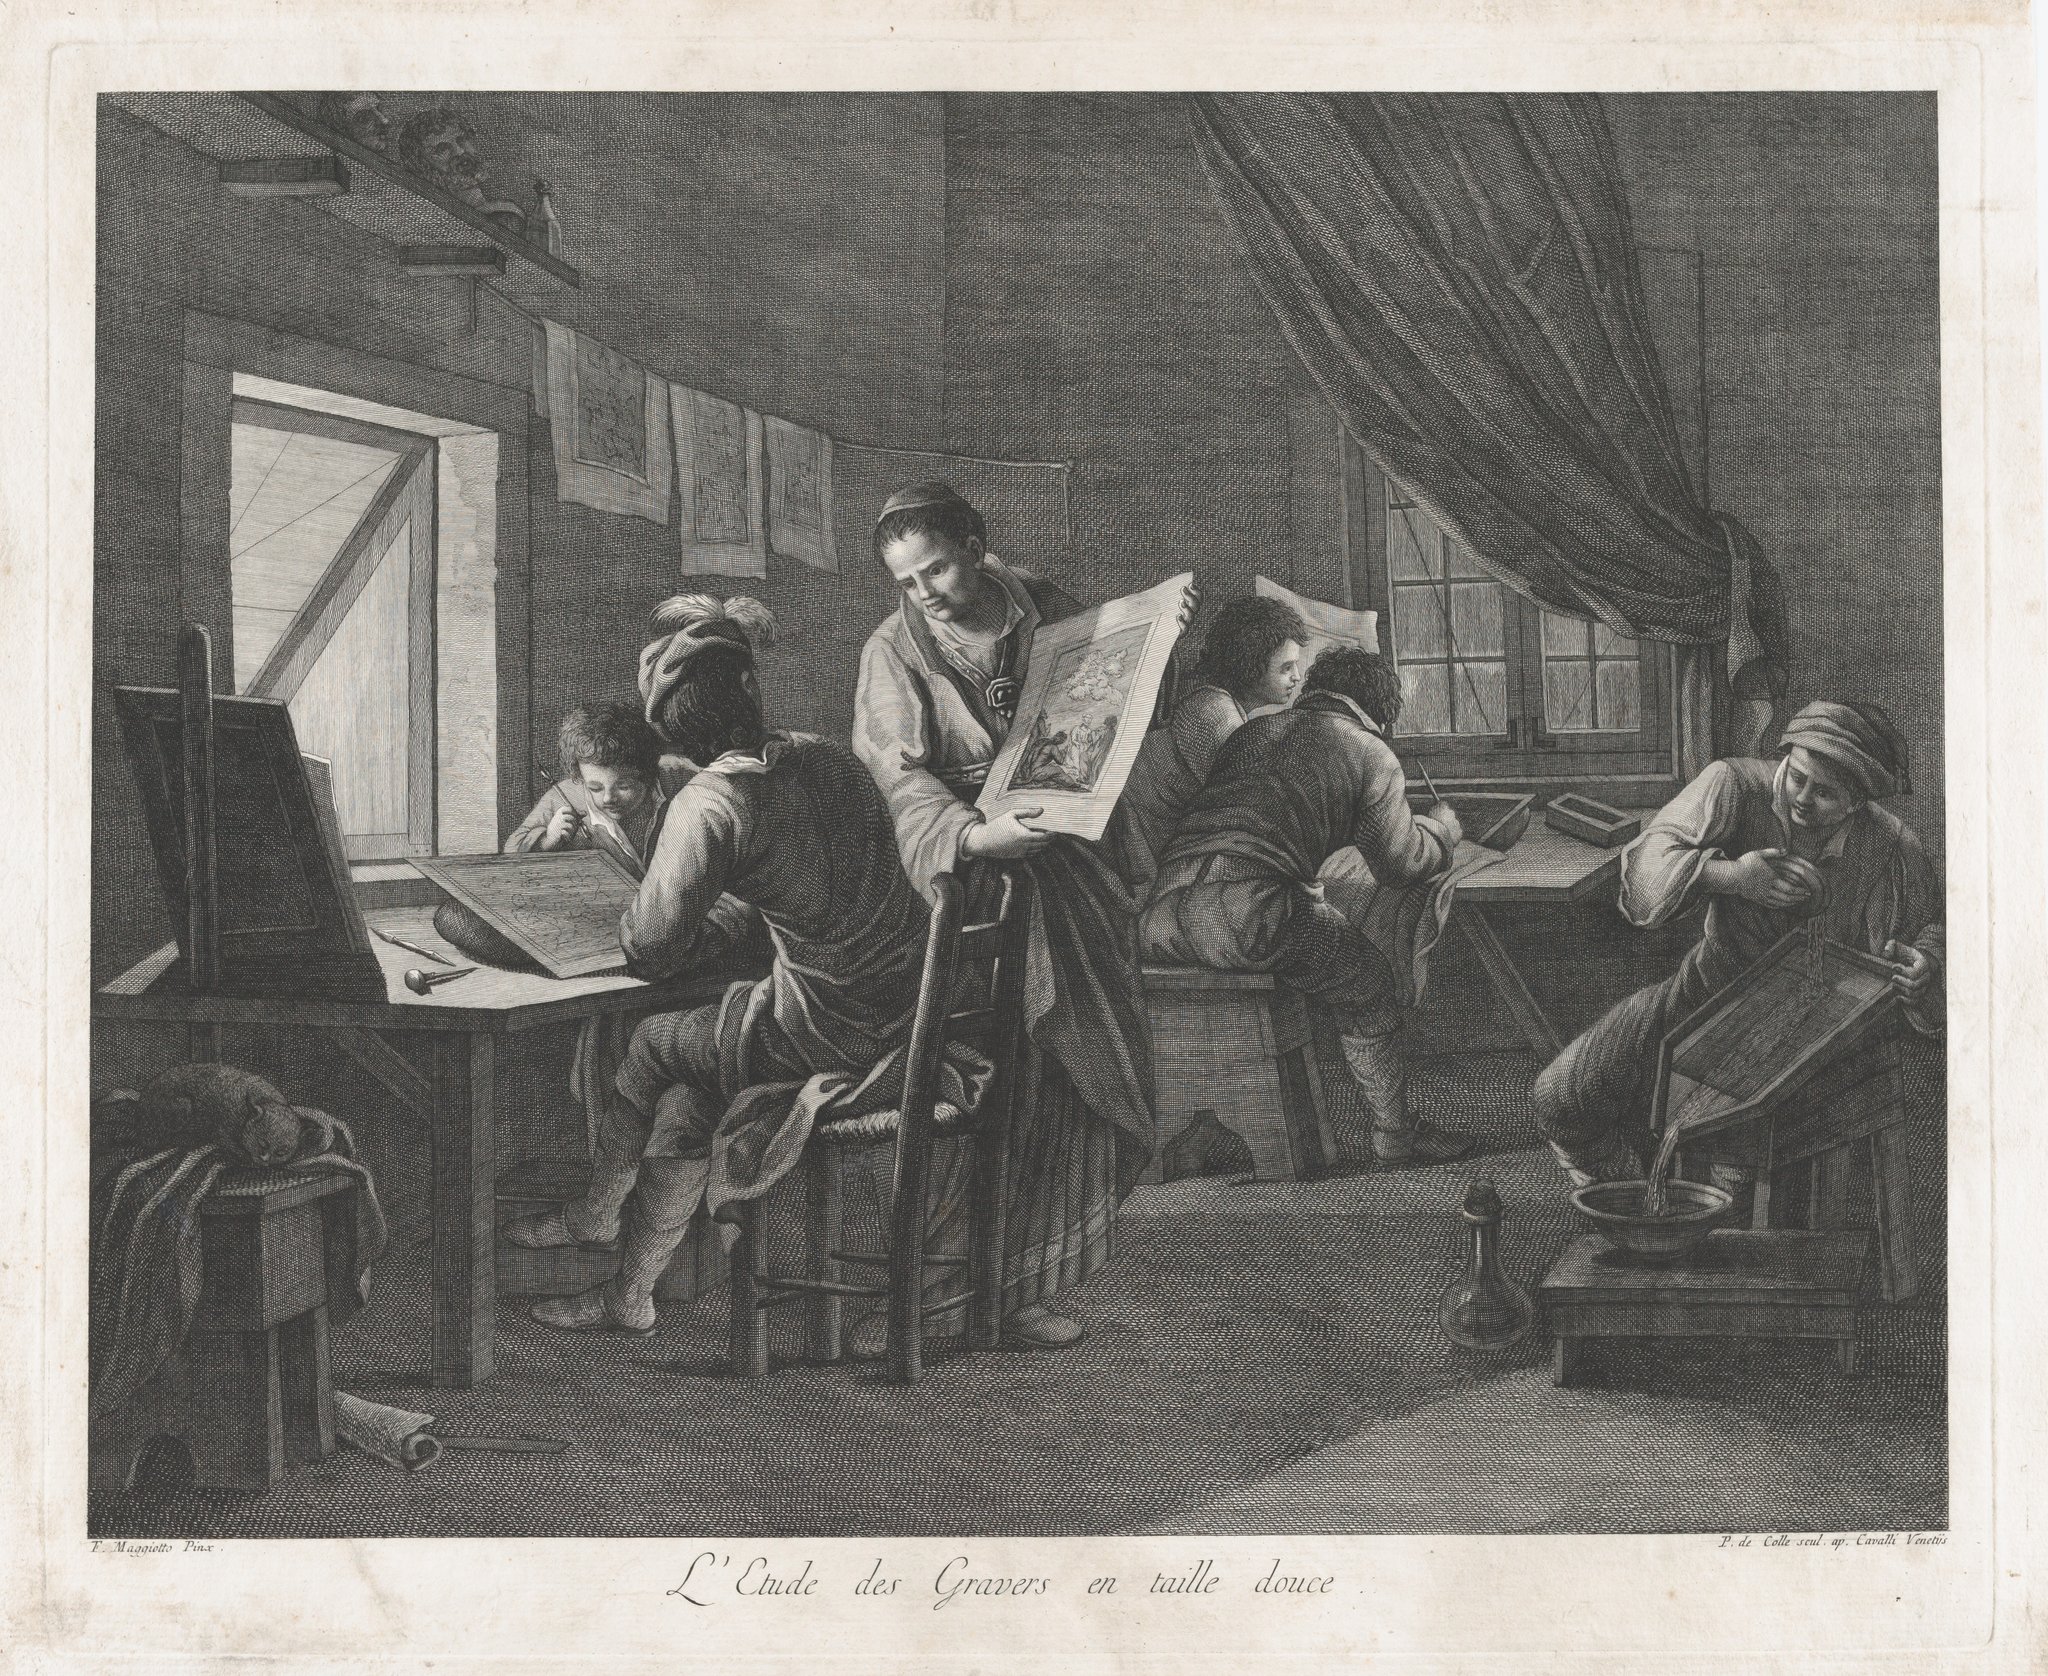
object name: print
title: The Printmaking Workshop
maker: pellegrino dal colle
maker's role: artist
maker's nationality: italian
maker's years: 1737-1812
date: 1750-1800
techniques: engraving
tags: men,working